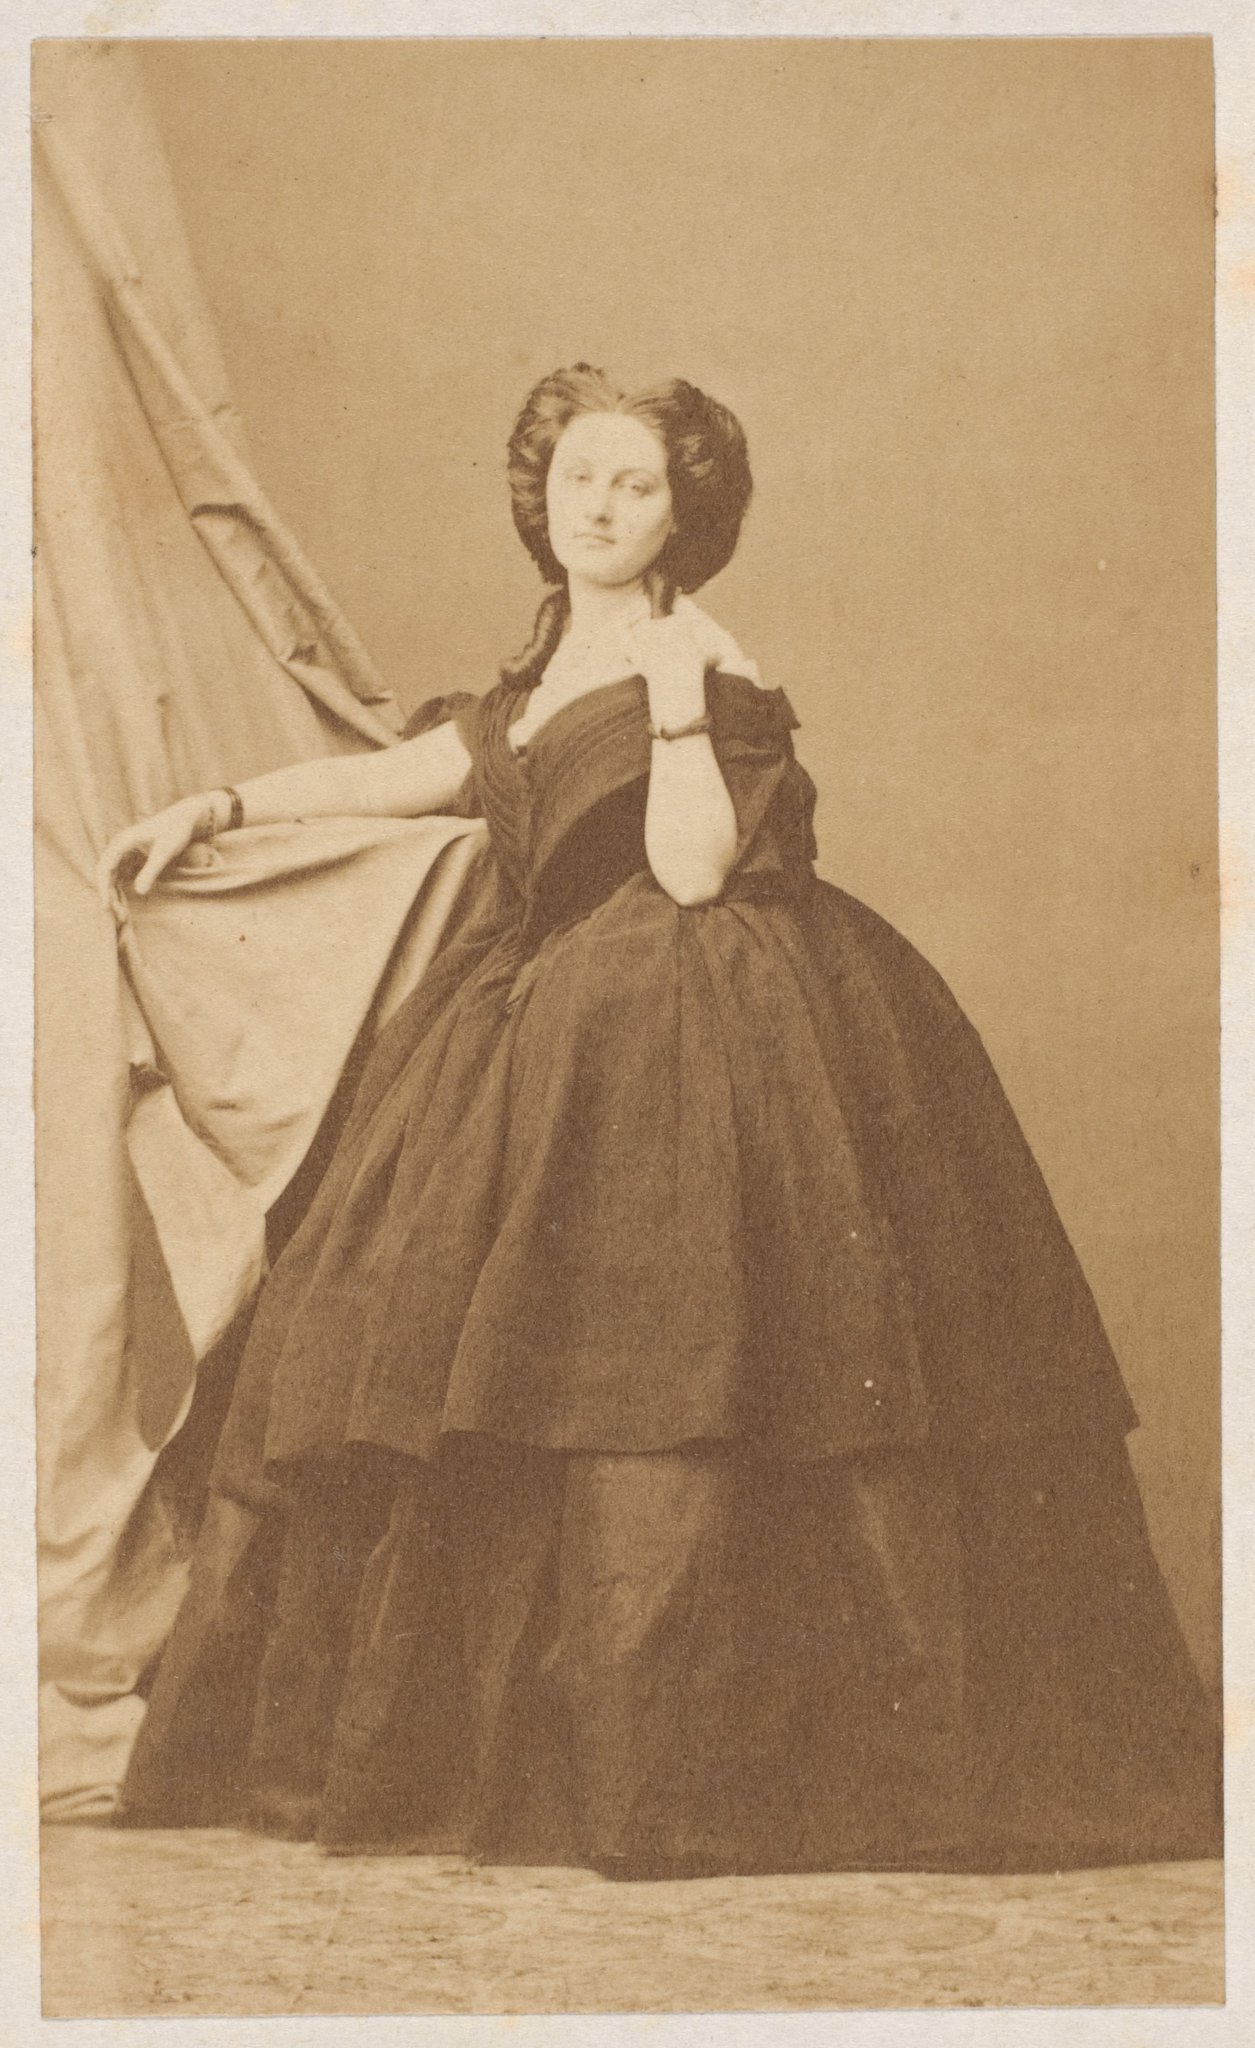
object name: photograph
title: Le beau bras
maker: pierre-louis pierson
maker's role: artist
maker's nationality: french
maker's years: 1822-1913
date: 1860-1869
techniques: albumen silver print, glass negative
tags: portraits,women